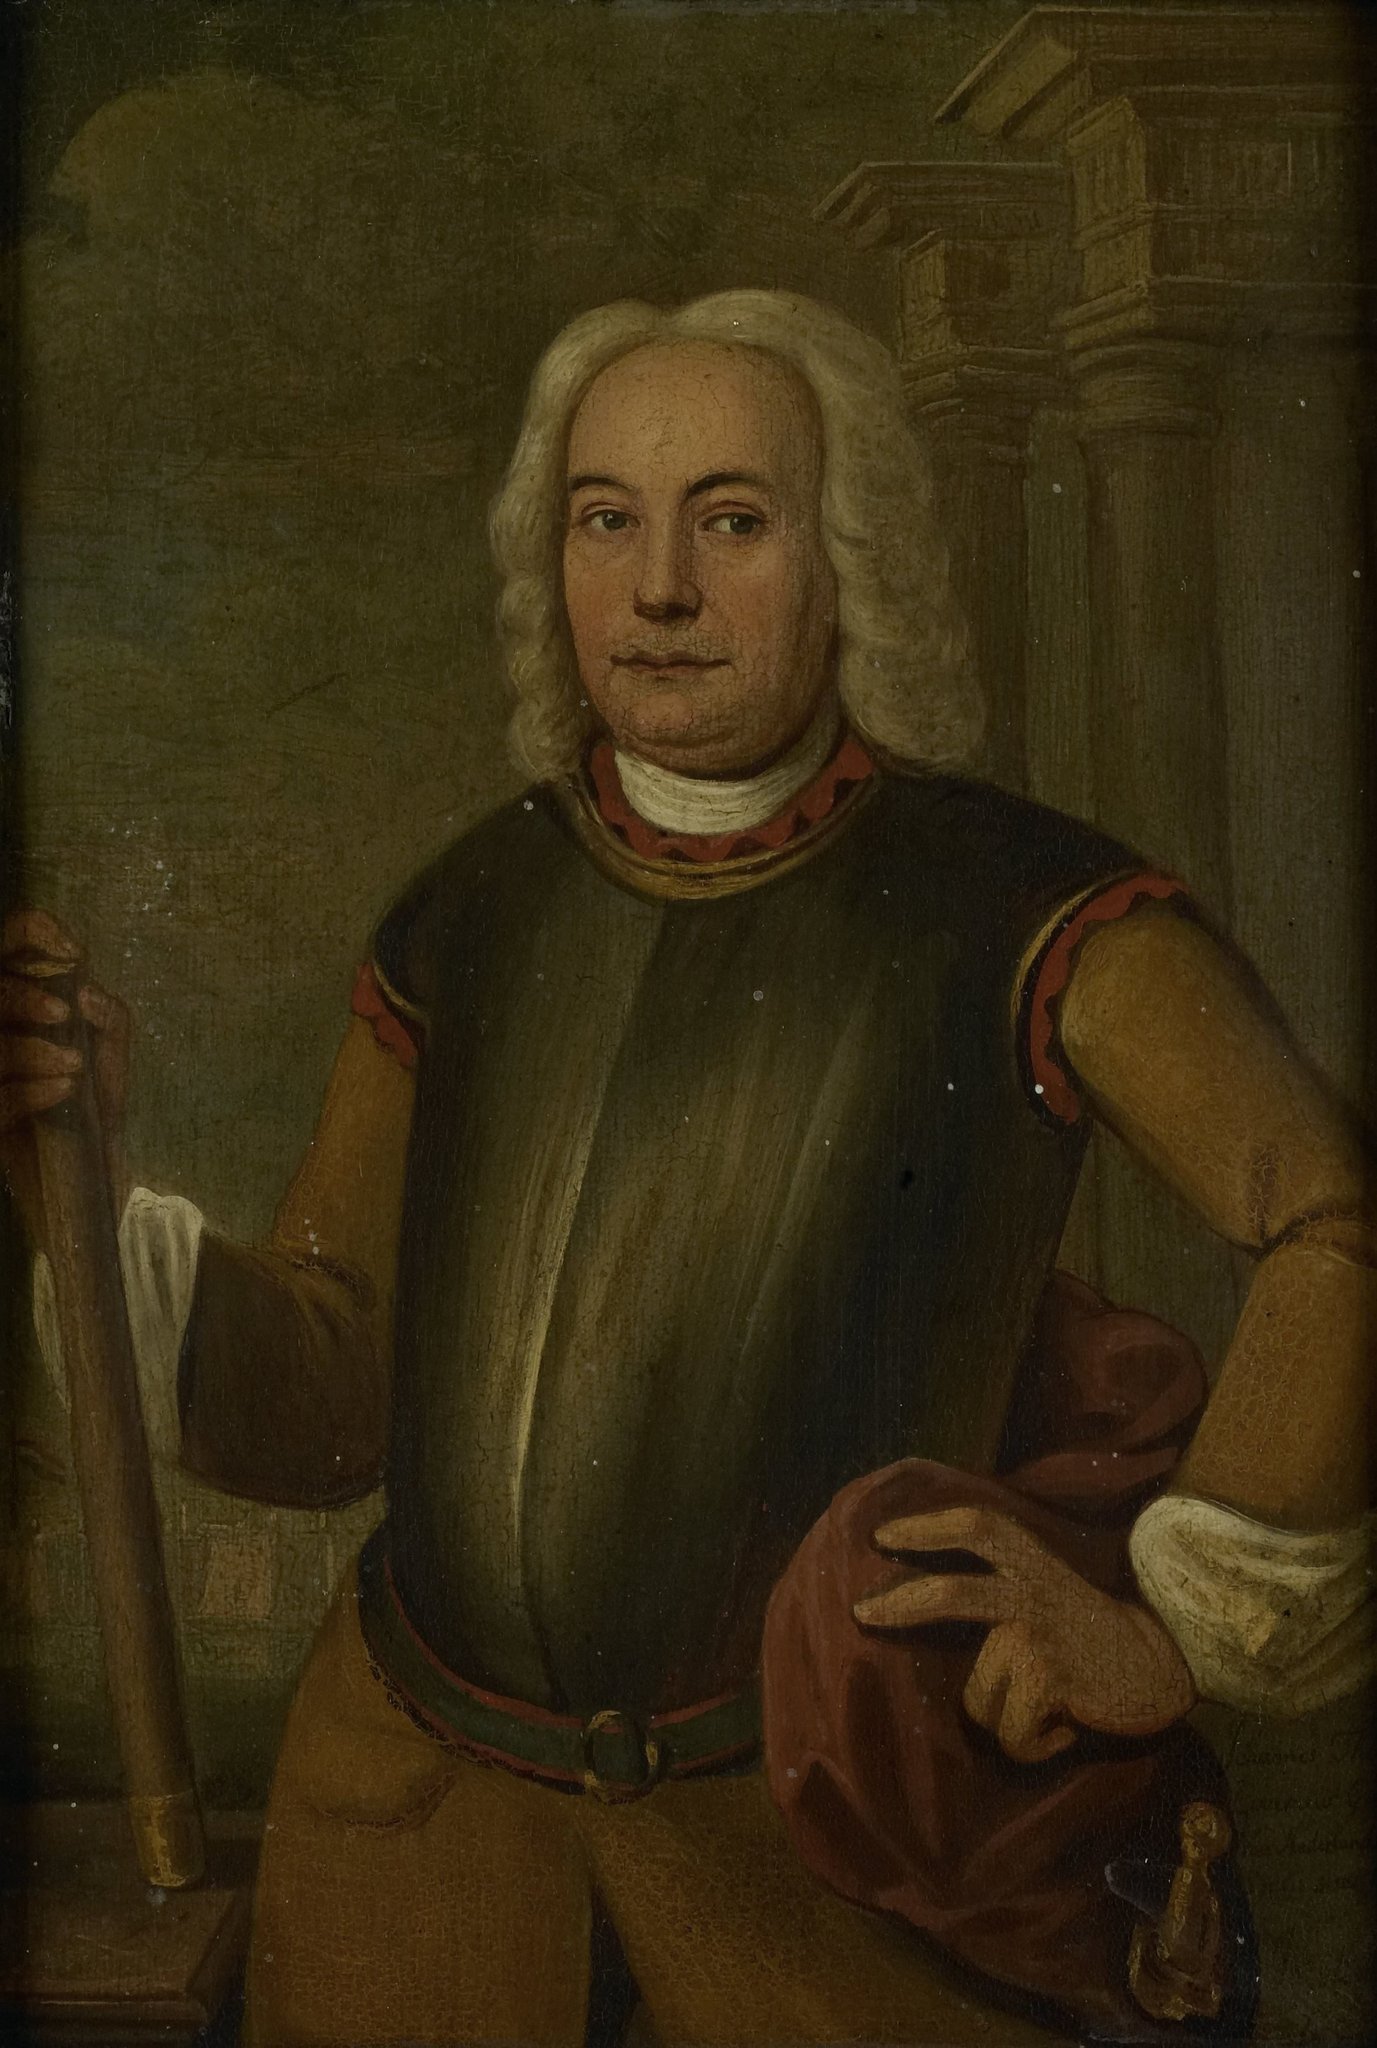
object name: painting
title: Portrait of Johannes Thedens, Governor-General of the Dutch East India Company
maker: jacobus oliphant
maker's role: painter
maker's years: 1715-1742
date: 1742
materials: copper, oil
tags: germany, batavia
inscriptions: inscription: ‘Johannes Thedens. Gouv. Gen. van Nederland. Indië Etatis Suae 64’, signature and date: ‘Ja.s oliphant Pinxit 1742’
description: Portret van Johannes Thedens (1680-1748). Gouverneur-generaal (1741-43). Staande, ten halven lijve, met borstharnas, commandostaf in de rechterhand, de linkerhand in de zij. Links in de achtergrond het kasteel van Batavia, rechts zuilen. Onderdeel van een reeks van kopieën naar portretten van de gouverneurs-generaal van het voormalige Nederlands Oost-Indië, waarschijnlijk afkomstig van de Verenigde Oostindische Compagnie. Vrije kopie naar SK-A-3779.